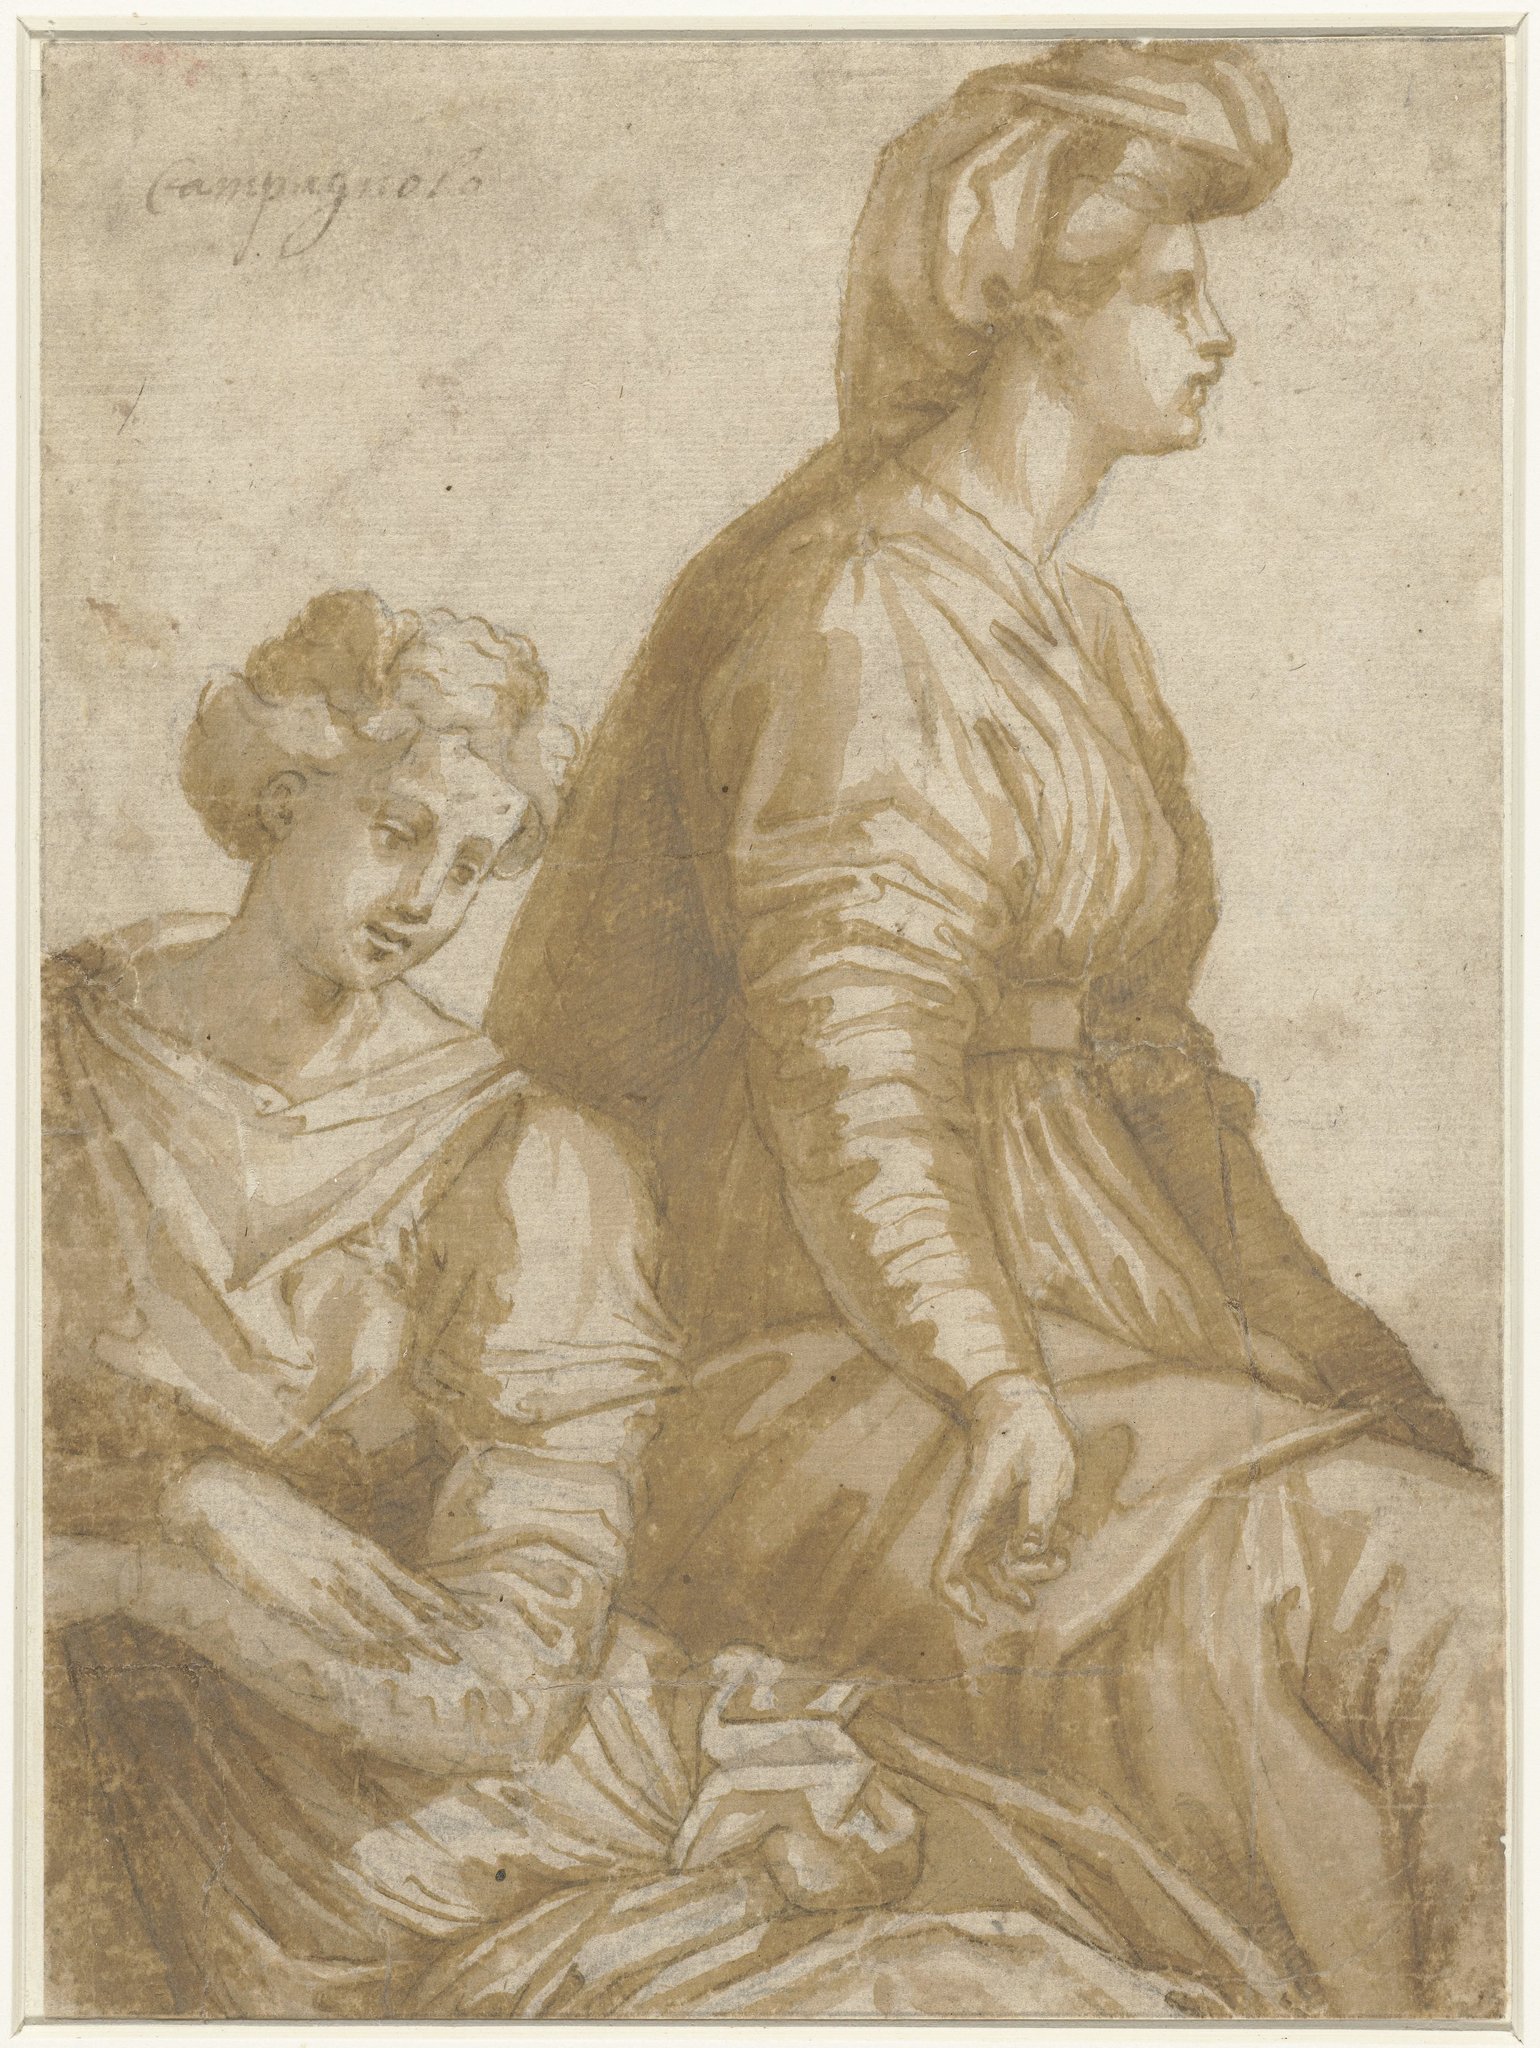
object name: drawing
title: Twee zittende vrouwen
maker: Anonymous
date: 1530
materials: chalk, ink, paper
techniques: brush, pen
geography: northern italy